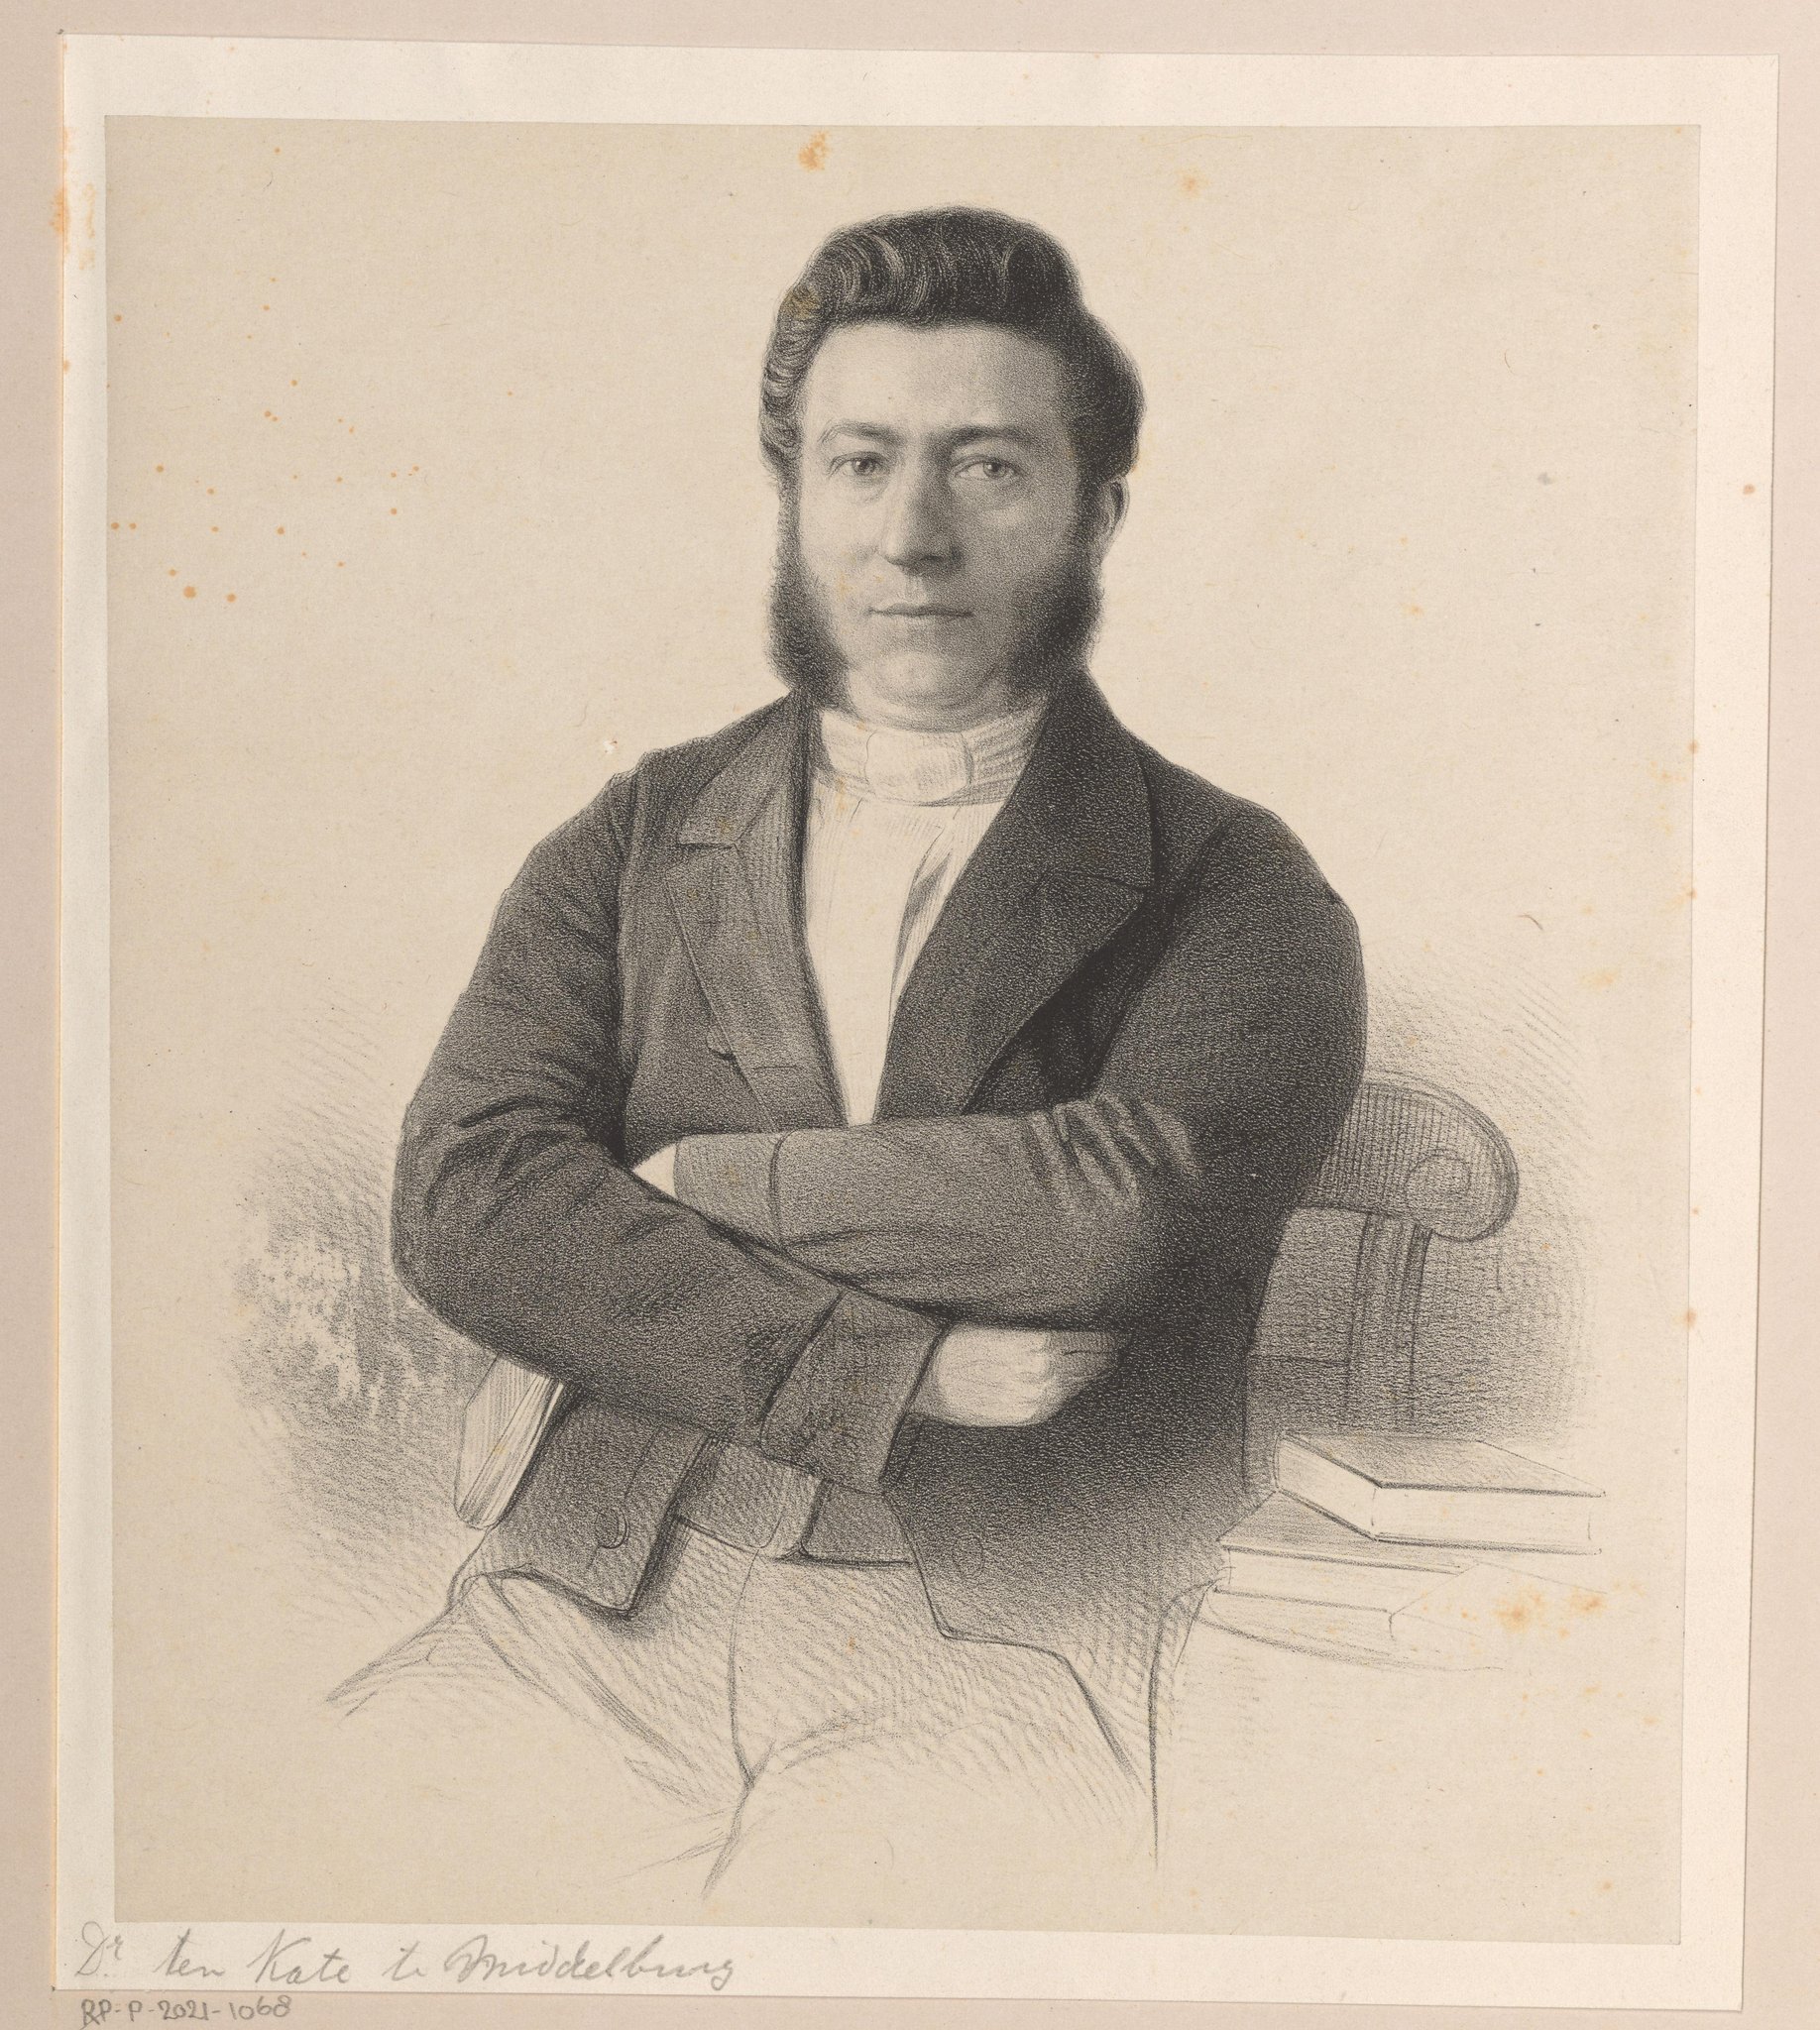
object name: print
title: Portret van Jan Jacob Lodewijk ten Kate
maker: Anonymous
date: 1839-1889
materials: paper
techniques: lithograph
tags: the hague, amsterdam, jan jakob lodewijk ten kate, historical persons, book, writer, poet, author